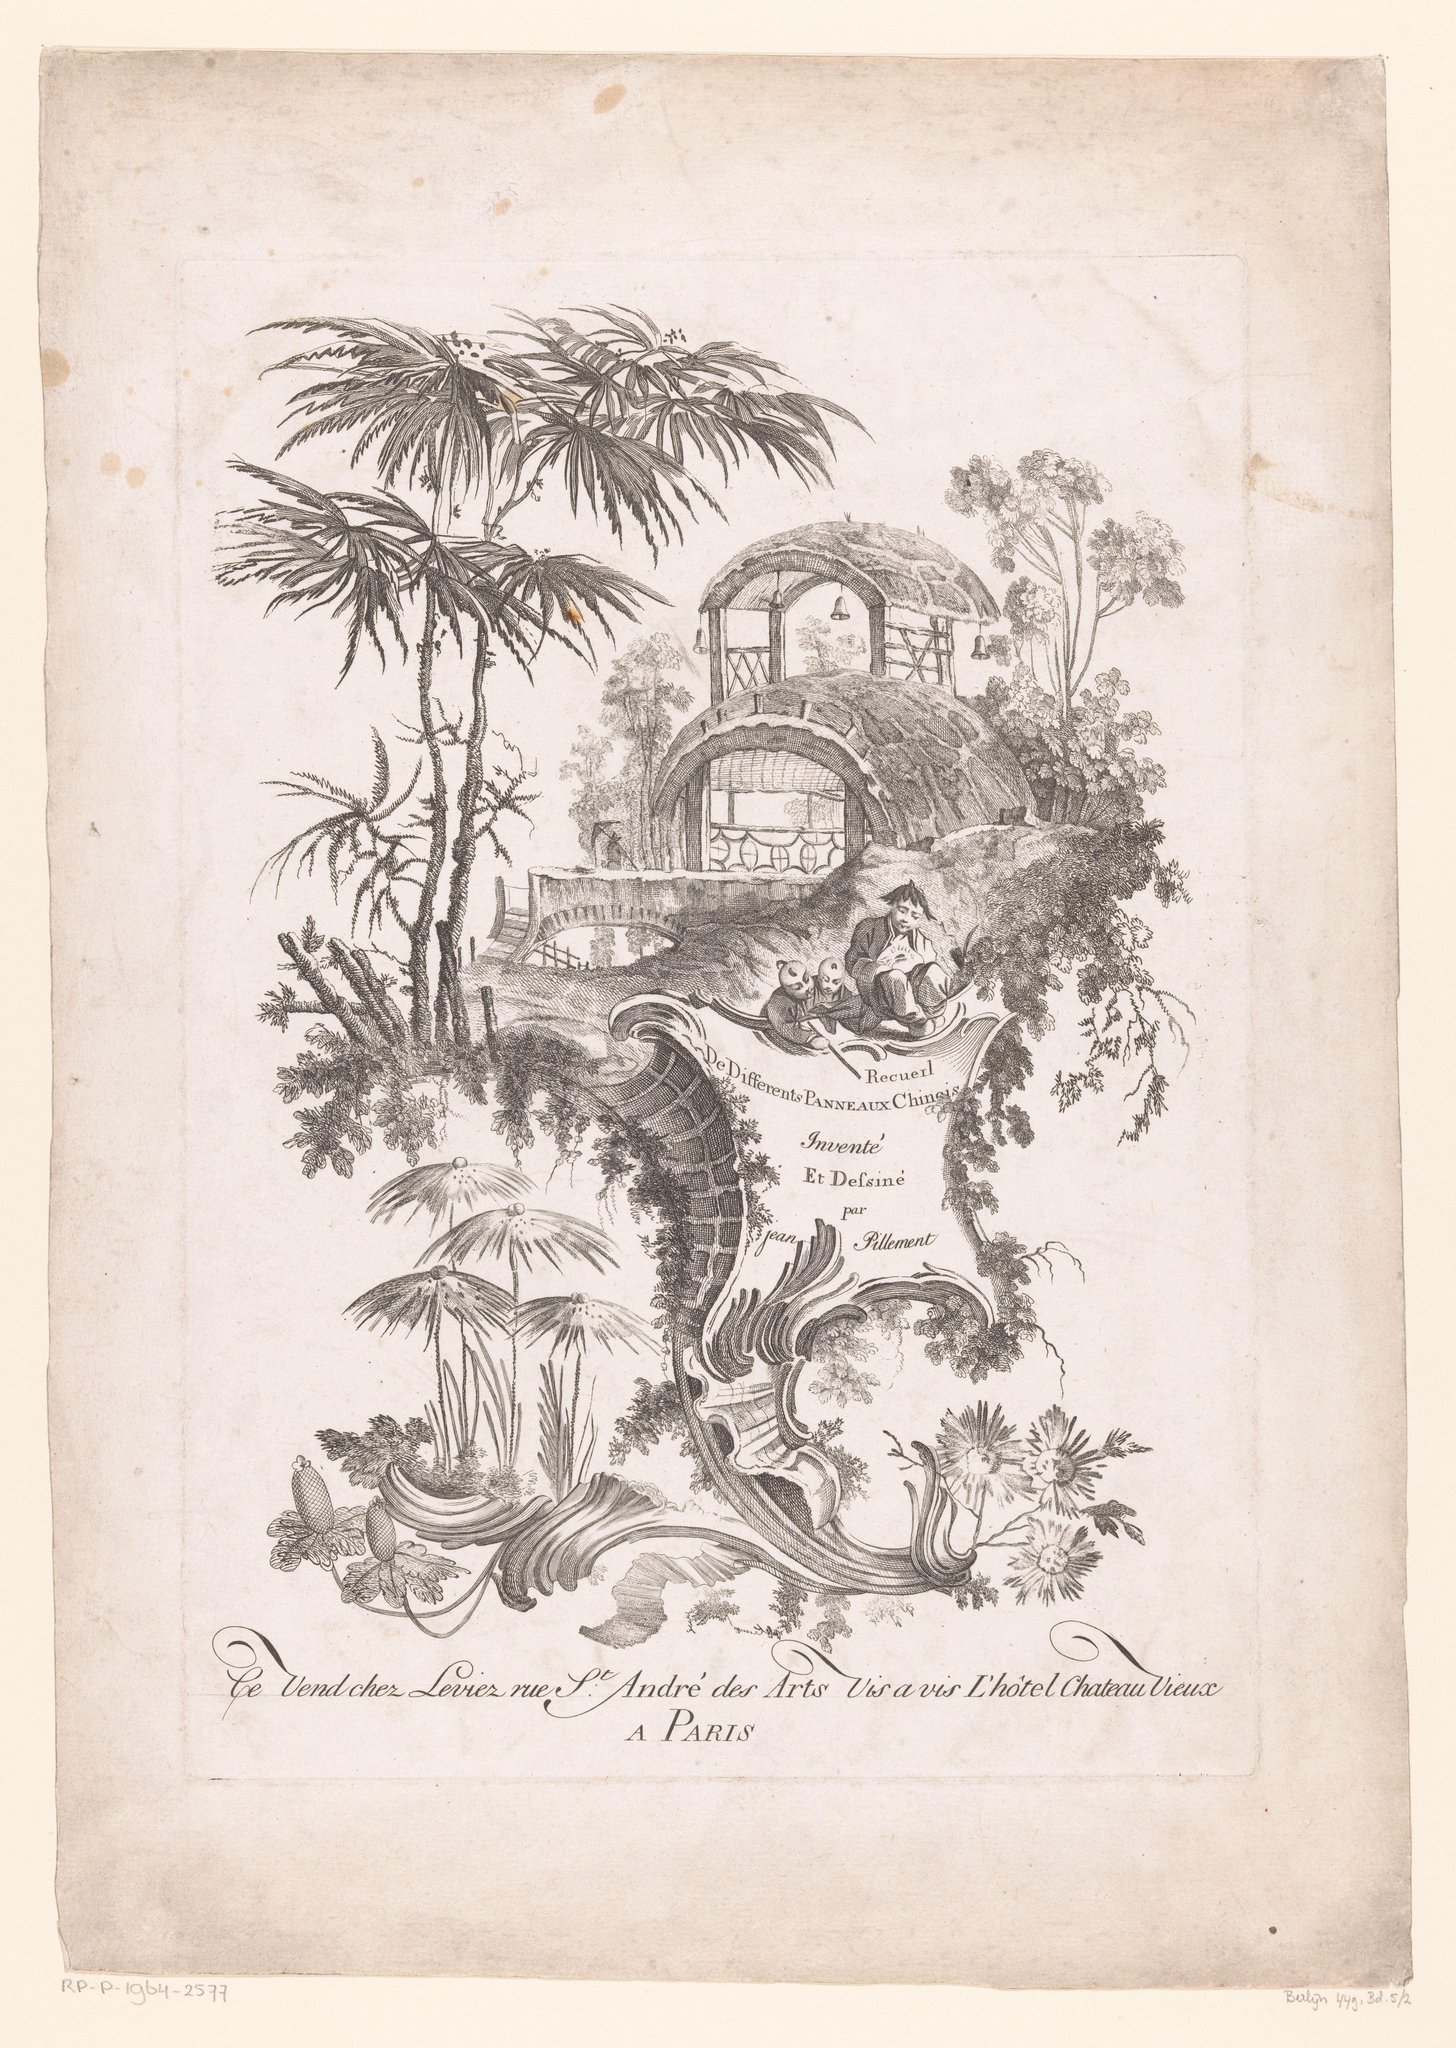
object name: ornament print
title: Drie figuren zittend voor gebouw met halfronde daken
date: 1755-1775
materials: paper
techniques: etching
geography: paris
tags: city-view, and landscape with man-made constructions - ii - ideal landscapes, sitting figure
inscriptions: collector's mark: Lugt 2228, collector's mark: Lugt 2760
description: Drie Chinese mannen zitten in een landschap voor een gebouw met twee halfronde daken. Onder hen een vierkant cartouche met de serietitel.